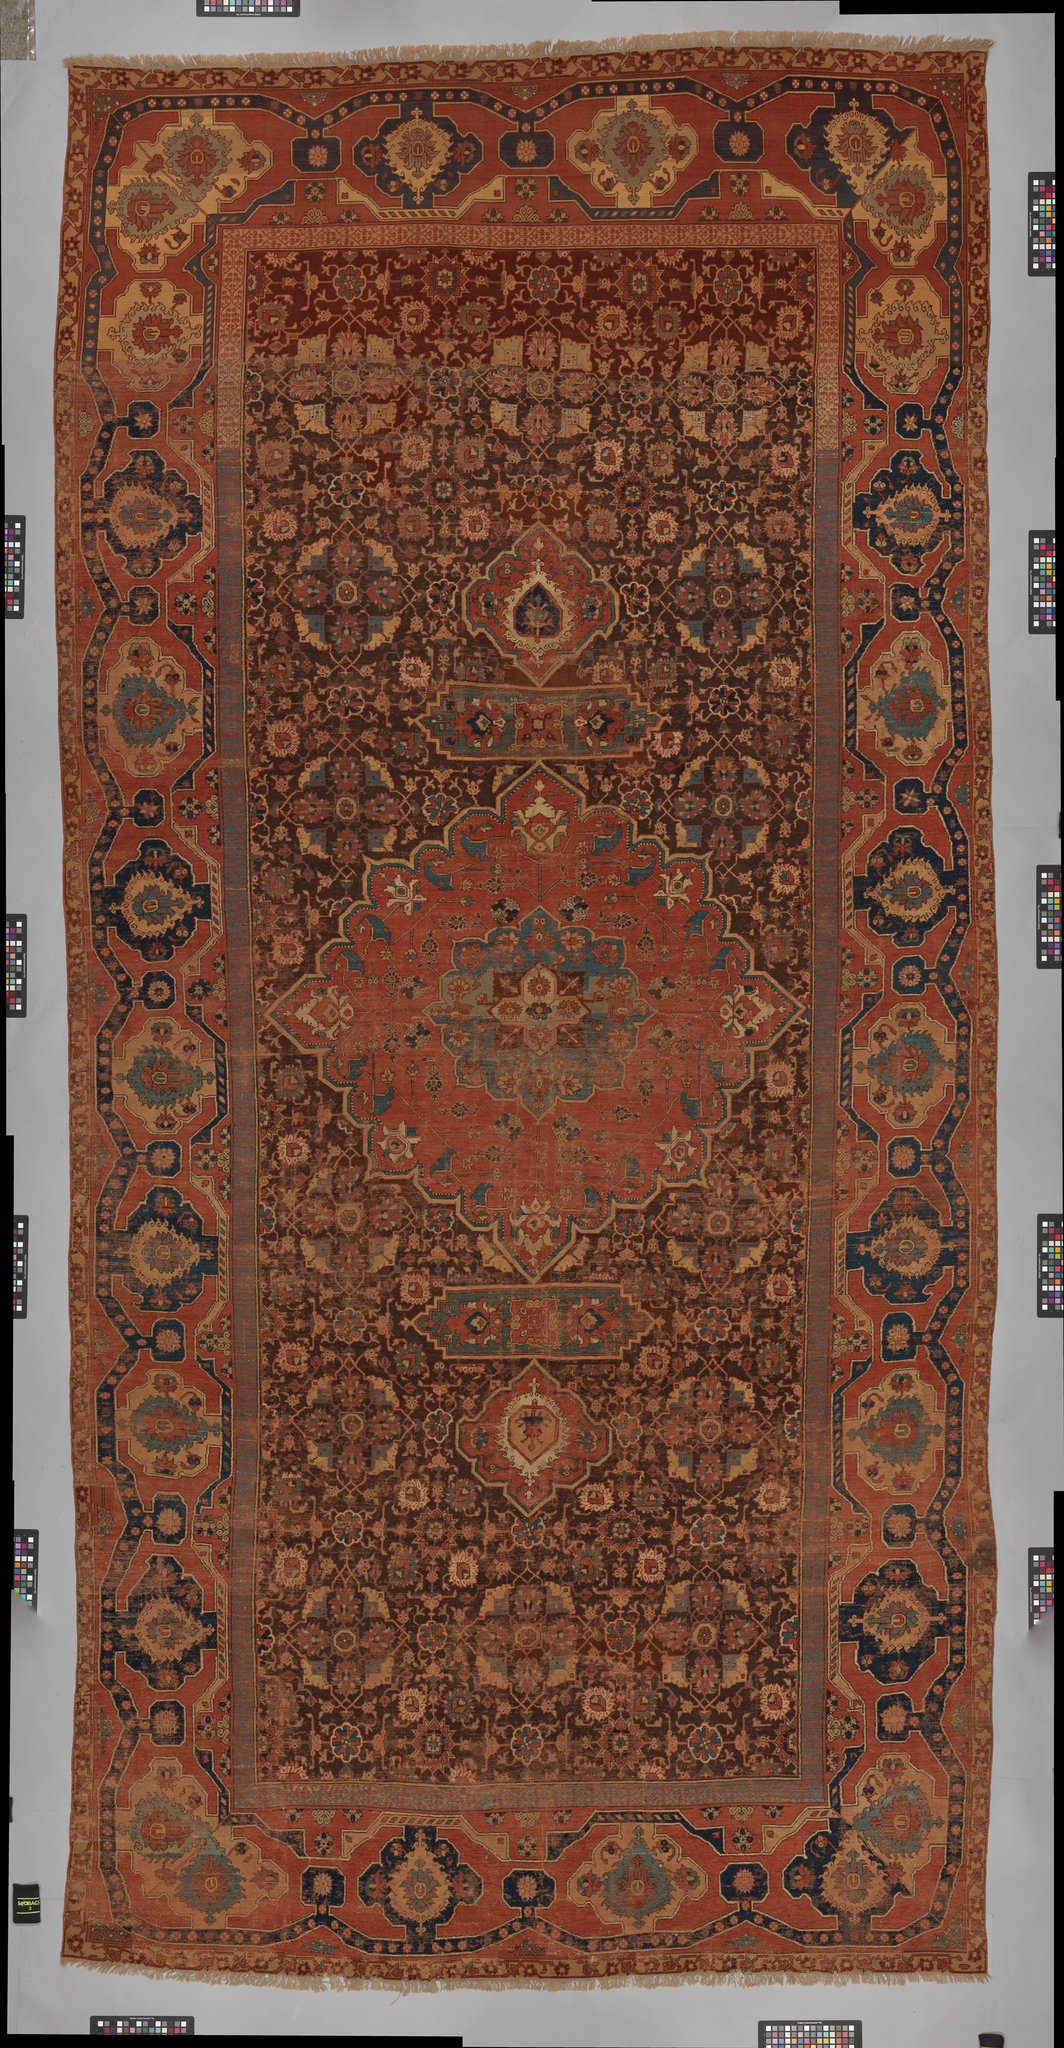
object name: carpet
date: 1601-1700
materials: wool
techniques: asymmetrically knotted pile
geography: northwestern iran